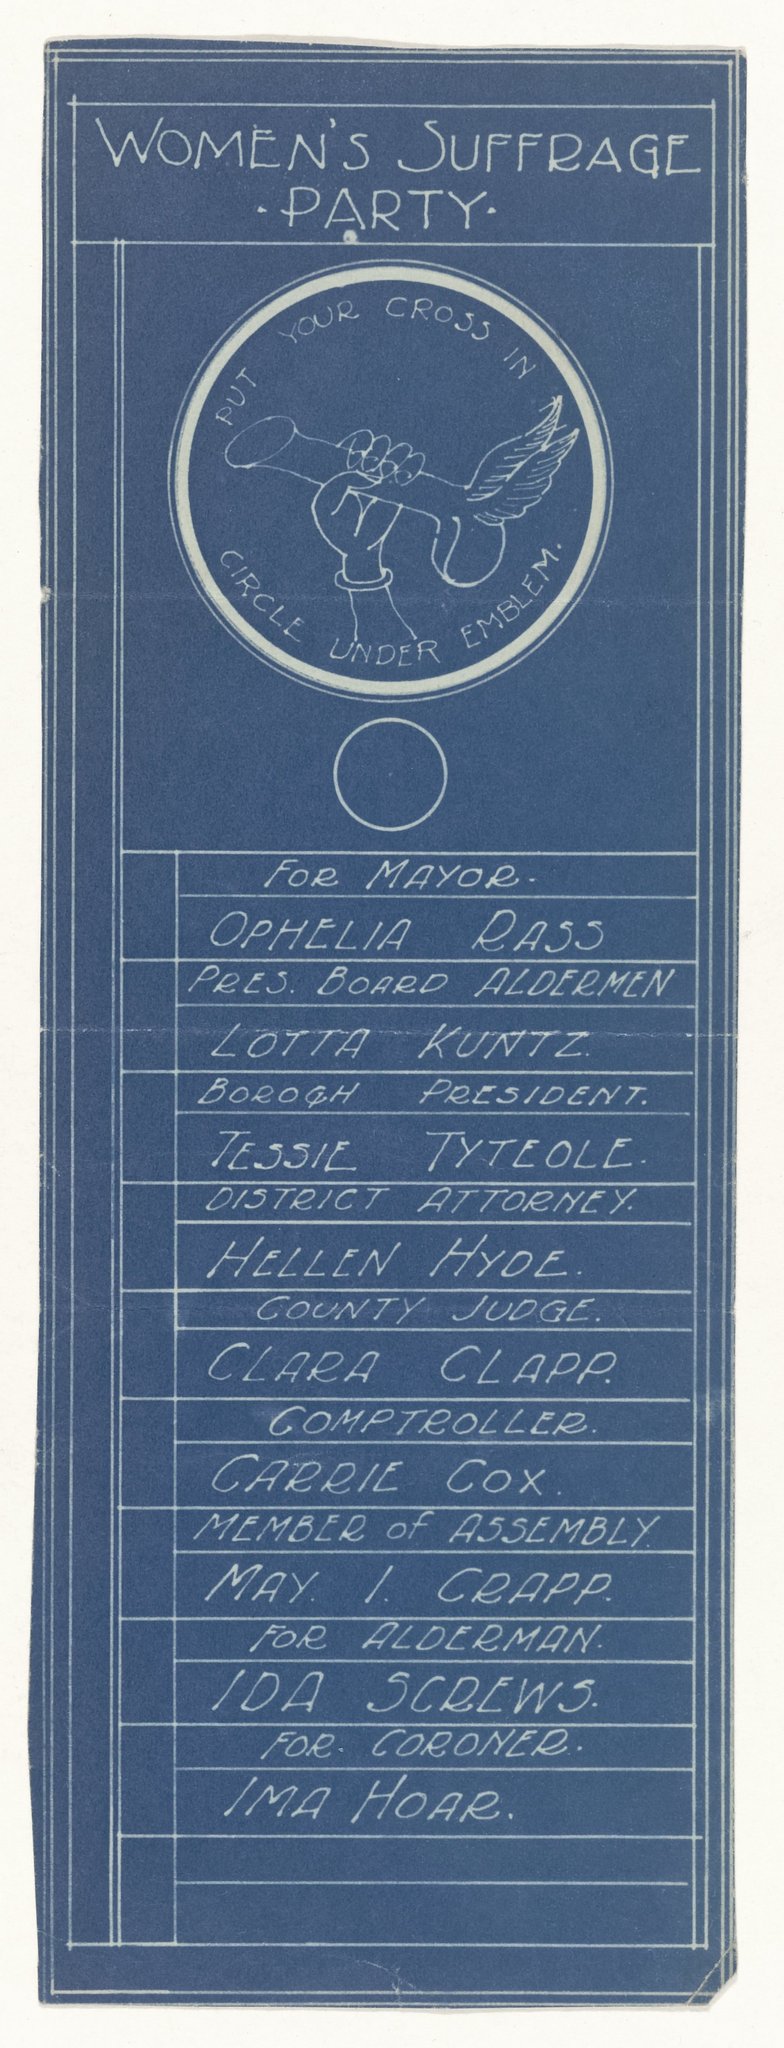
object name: reproduction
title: Women’s Suffrage Party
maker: Anonymous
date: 1900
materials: paper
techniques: cyanotype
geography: united states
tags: 'suffragette', scabrous scenes, pornography, voting ballot, penis, phallus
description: Pastiche op een stembiljet van de Women’s Suffrage Party.